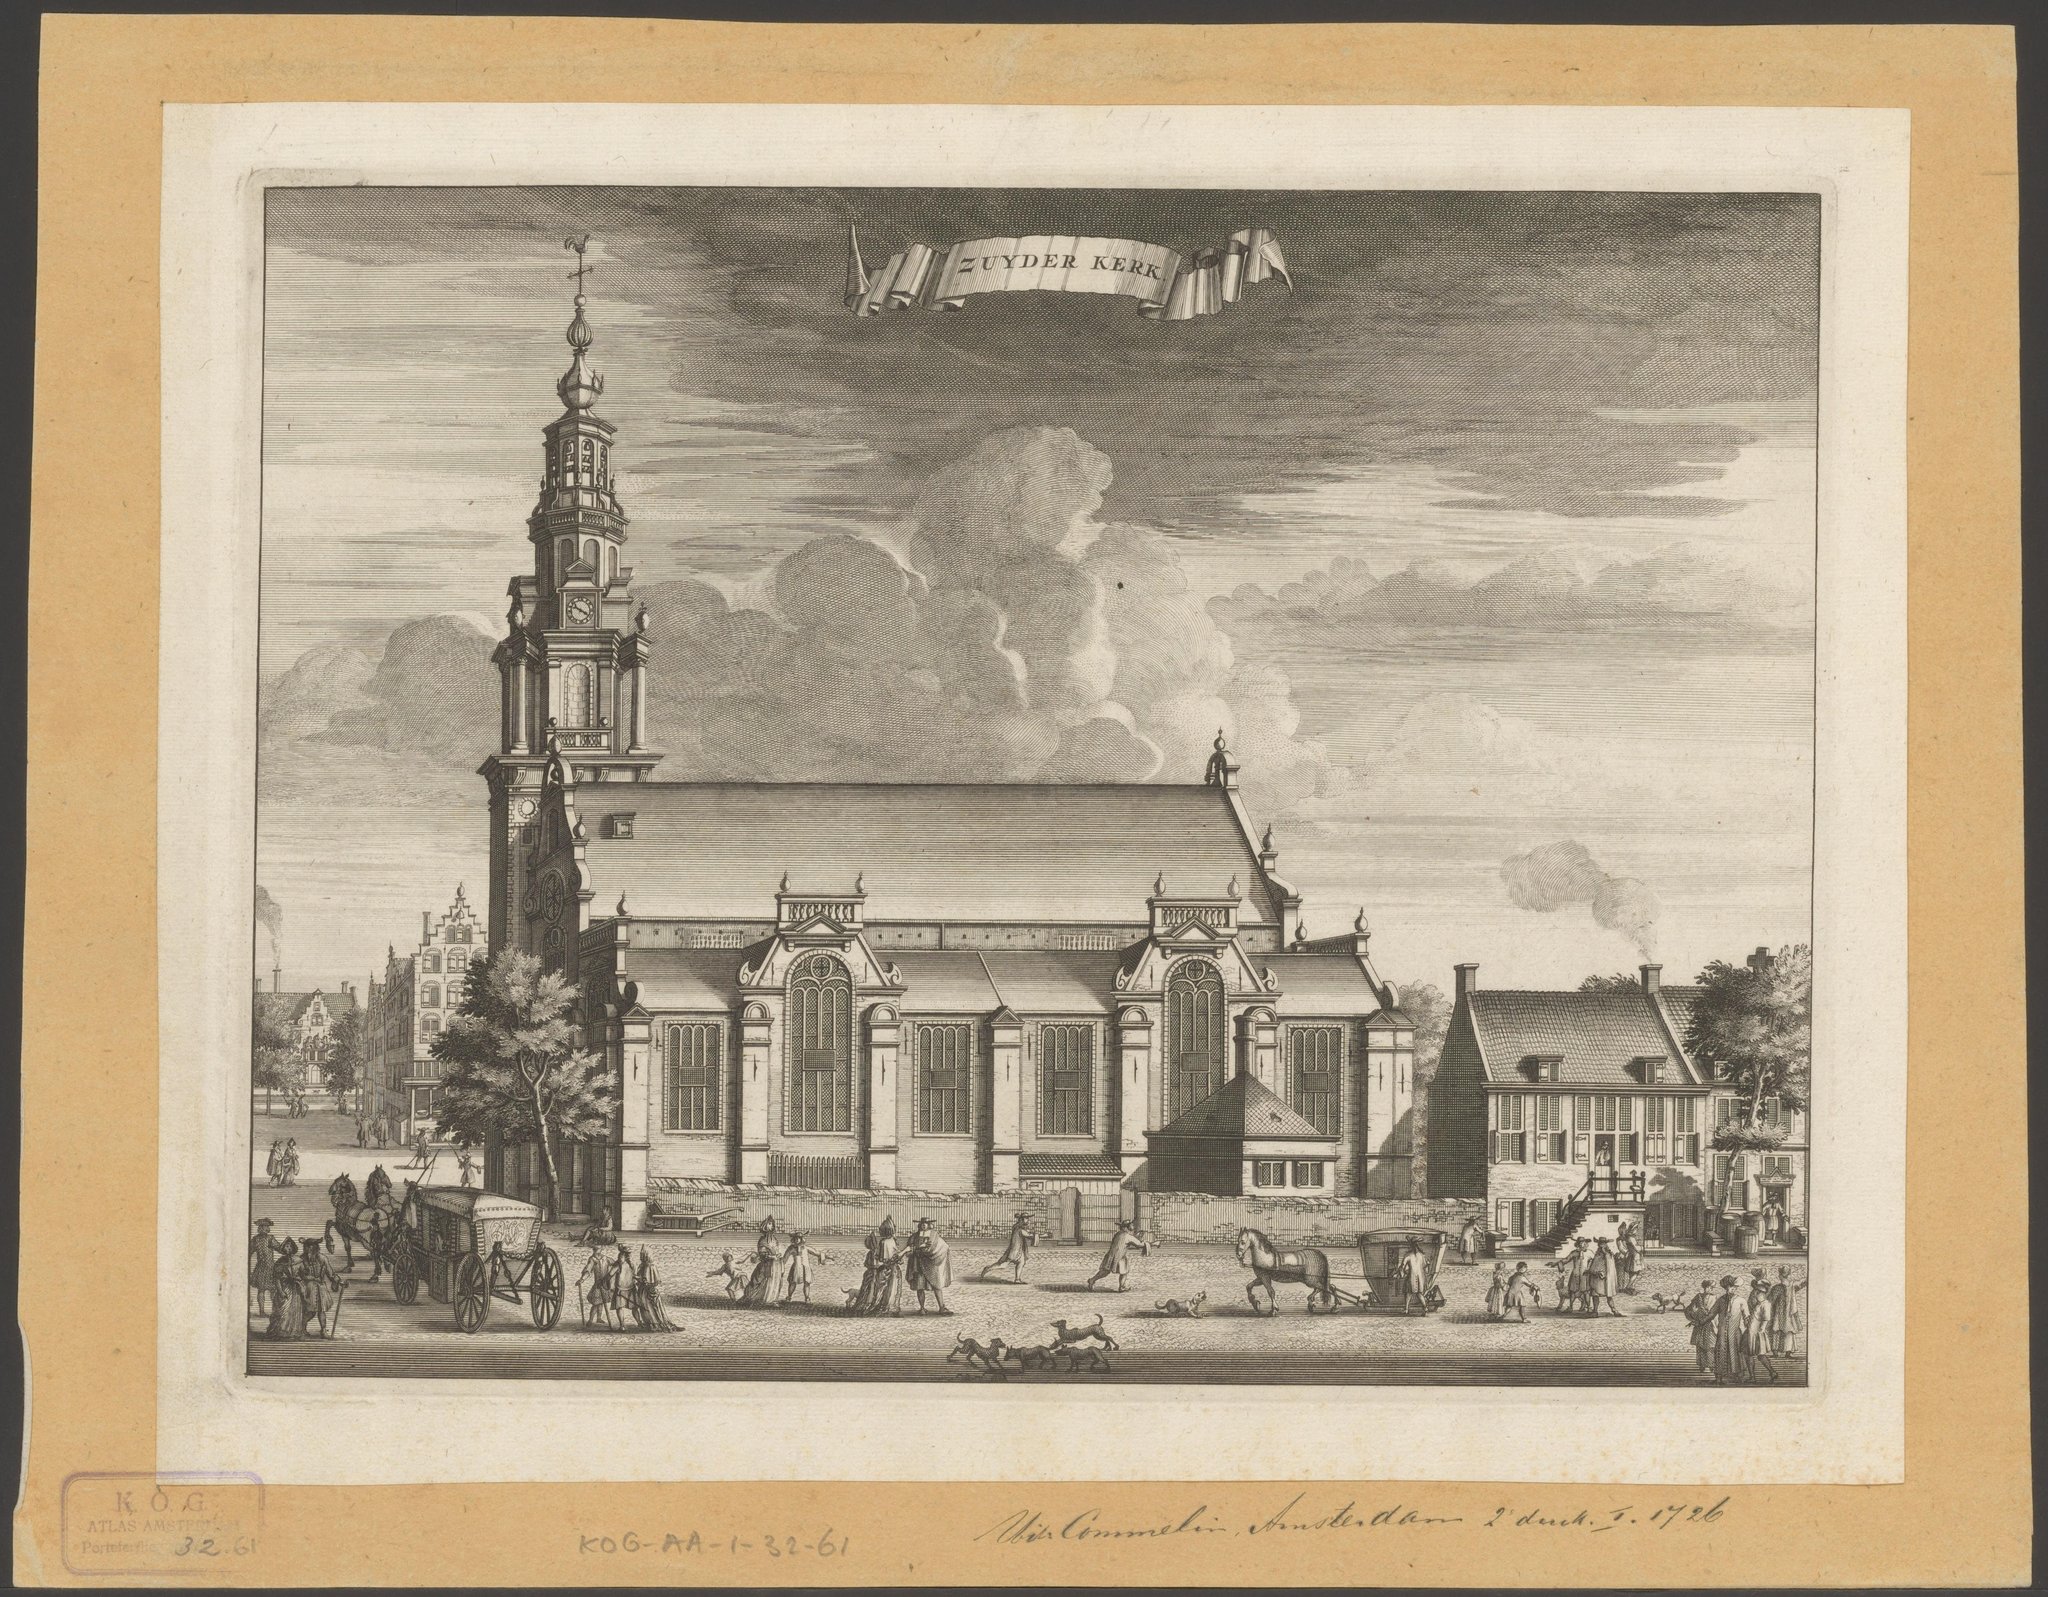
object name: print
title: Zuyder Kerk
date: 1726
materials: paper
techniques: engraving, etching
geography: northern netherlands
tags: church (exterior), street (+ city(-scape) with figures, staffage)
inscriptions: collector's mark: Lugt 1641b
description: Prent mogelijk uit: Commelin, Casparus. Beschryvinge van Amsterdam (…). 2de druk. Amsterdam: Andries van Damme, Johannes Ratelband, weduwe Antony van Aeltwijk en Hermanus Uytwerf, 1726, dl. 1.